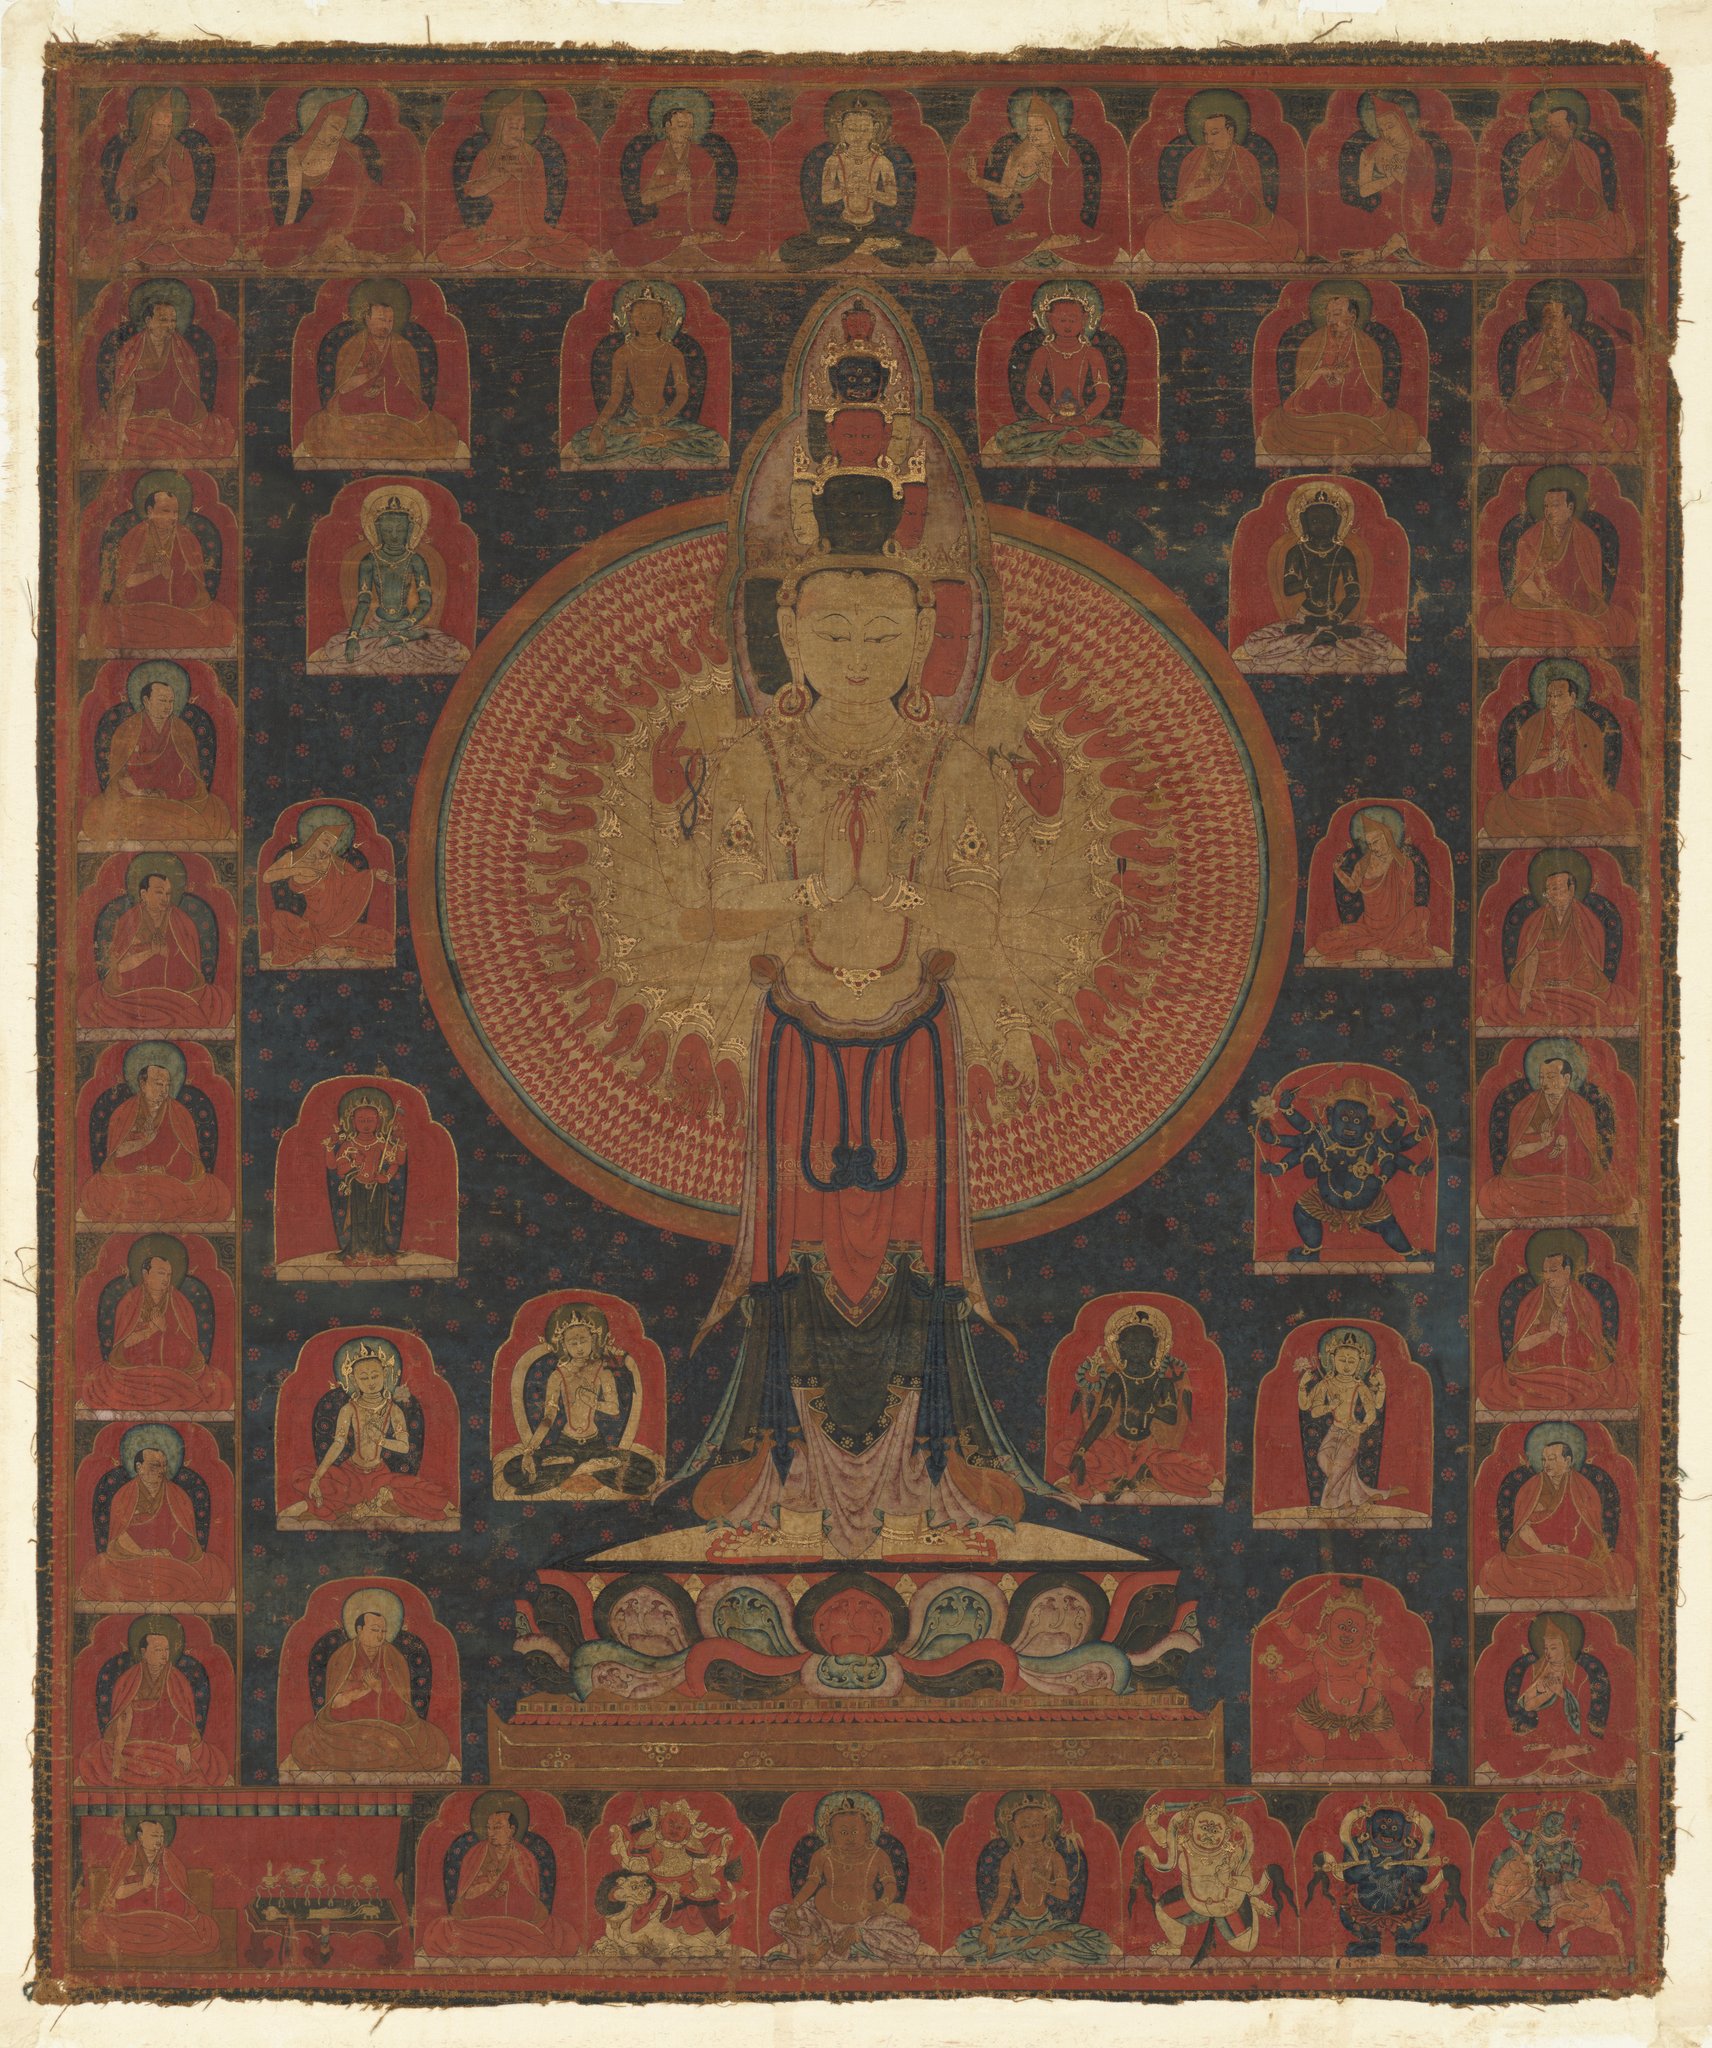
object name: thangka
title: Thousand-Armed Chenresi, a Cosmic Form of the Bodhisattva Avalokiteshvara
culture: tibetan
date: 1301-1400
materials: textile, gold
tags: buddhism,avalokiteshvara,bodhisattvas,deities